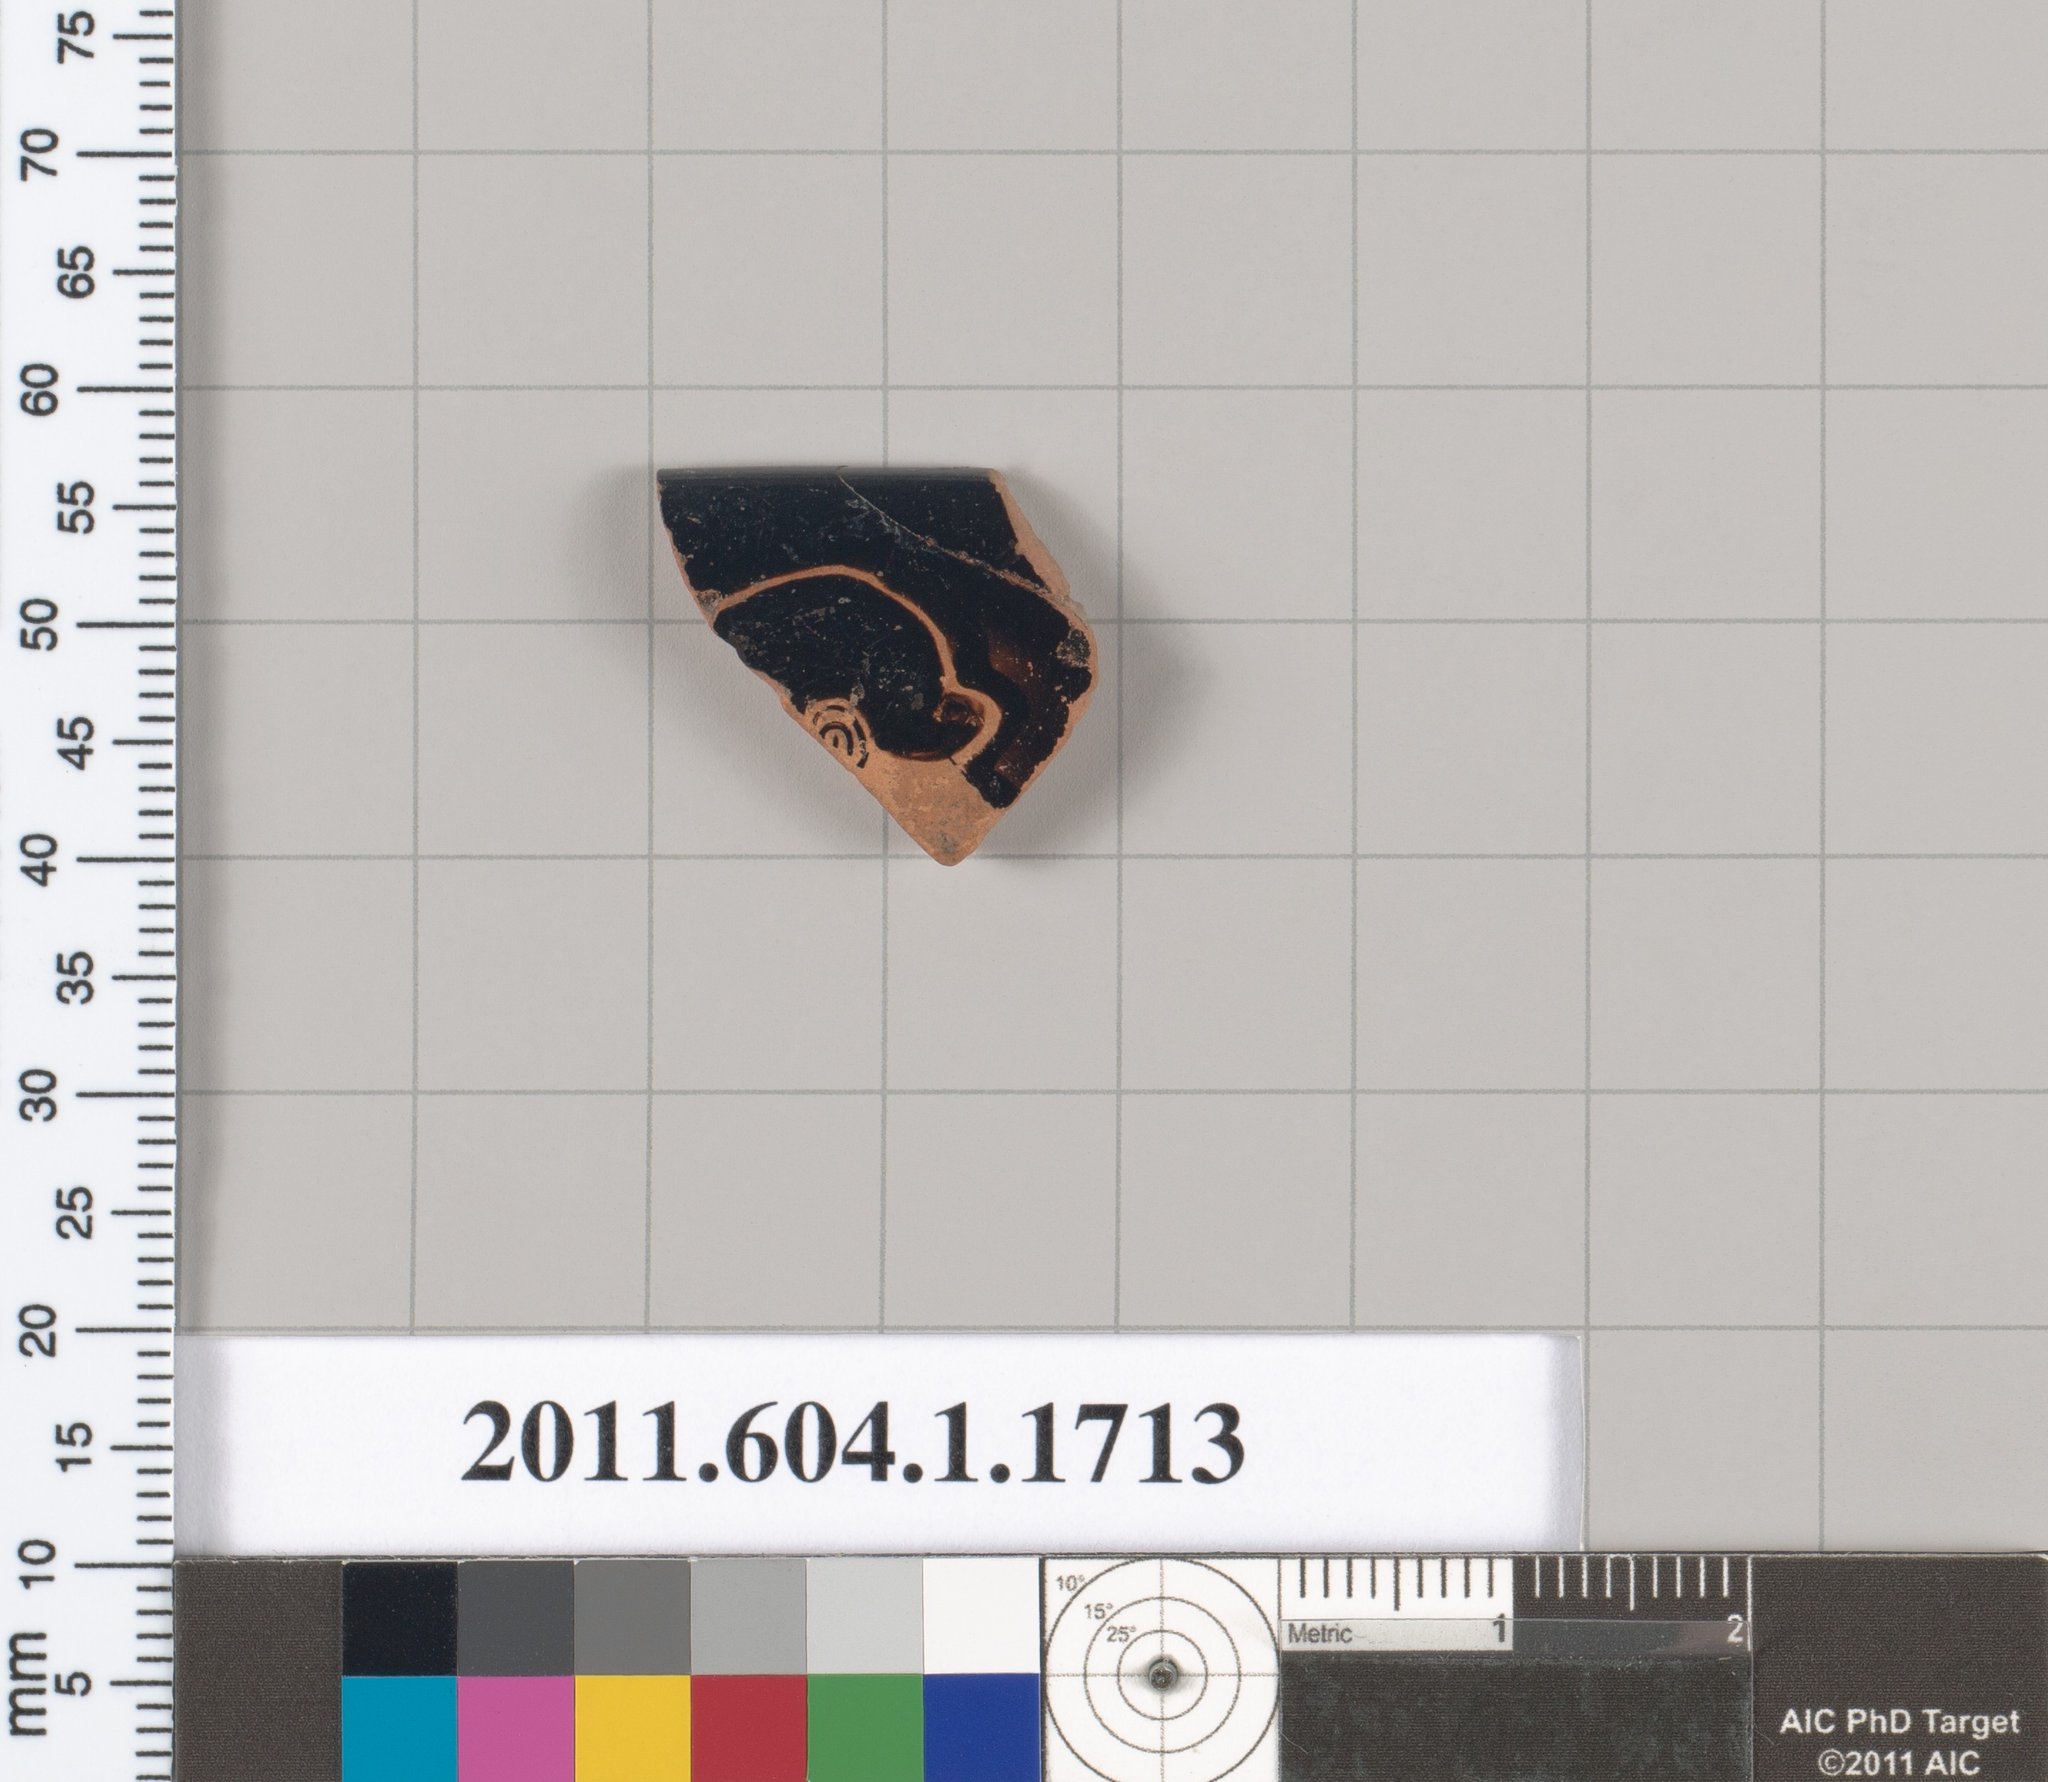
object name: kylix fragment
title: Terracotta rim fragment of a kylix (drinking cup)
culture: greek, attic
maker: telephos painter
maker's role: artist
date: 480-470 BCE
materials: terracotta